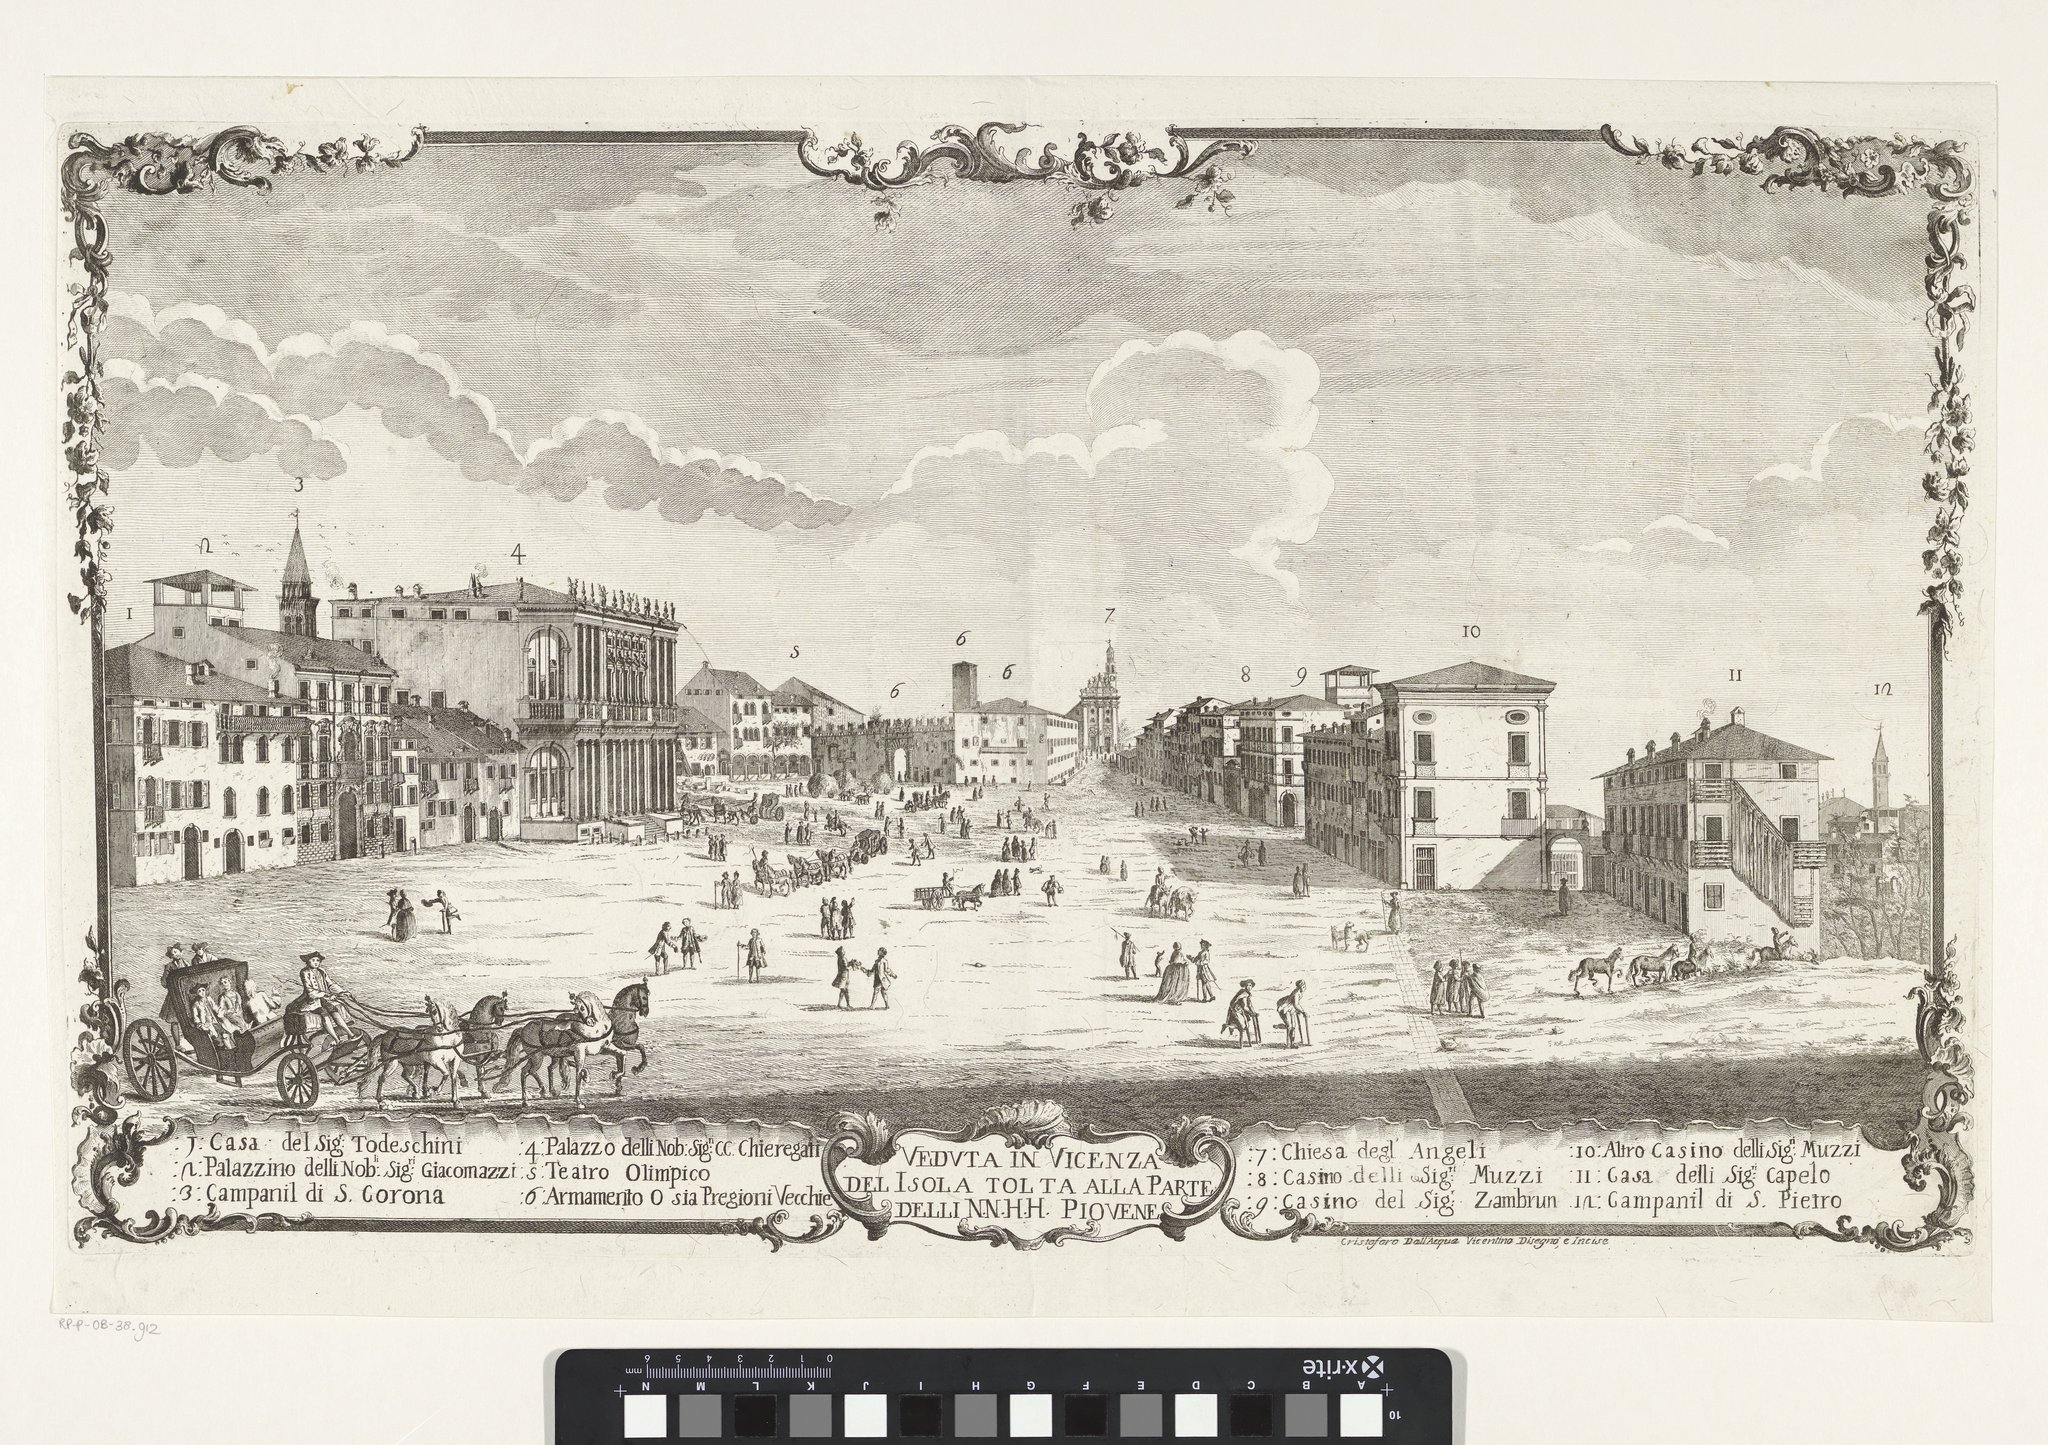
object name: print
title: Isola Tolta in Vicenza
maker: cristoforo dall acqua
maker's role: draughtsman, print maker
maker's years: 1734-1787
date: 1744-1787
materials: paper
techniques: etching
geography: italy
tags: parts of church exterior and annexes: campanile, square, place, circus, etc., city-view, and landscape with man-made constructions, hôtel, i.e. small palace in city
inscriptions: collector's mark: Lugt 2228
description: Gezicht op het Isola Tolta in Vicenza. Verklarende lijst met nummers en titel in cartouche in ondermarge.